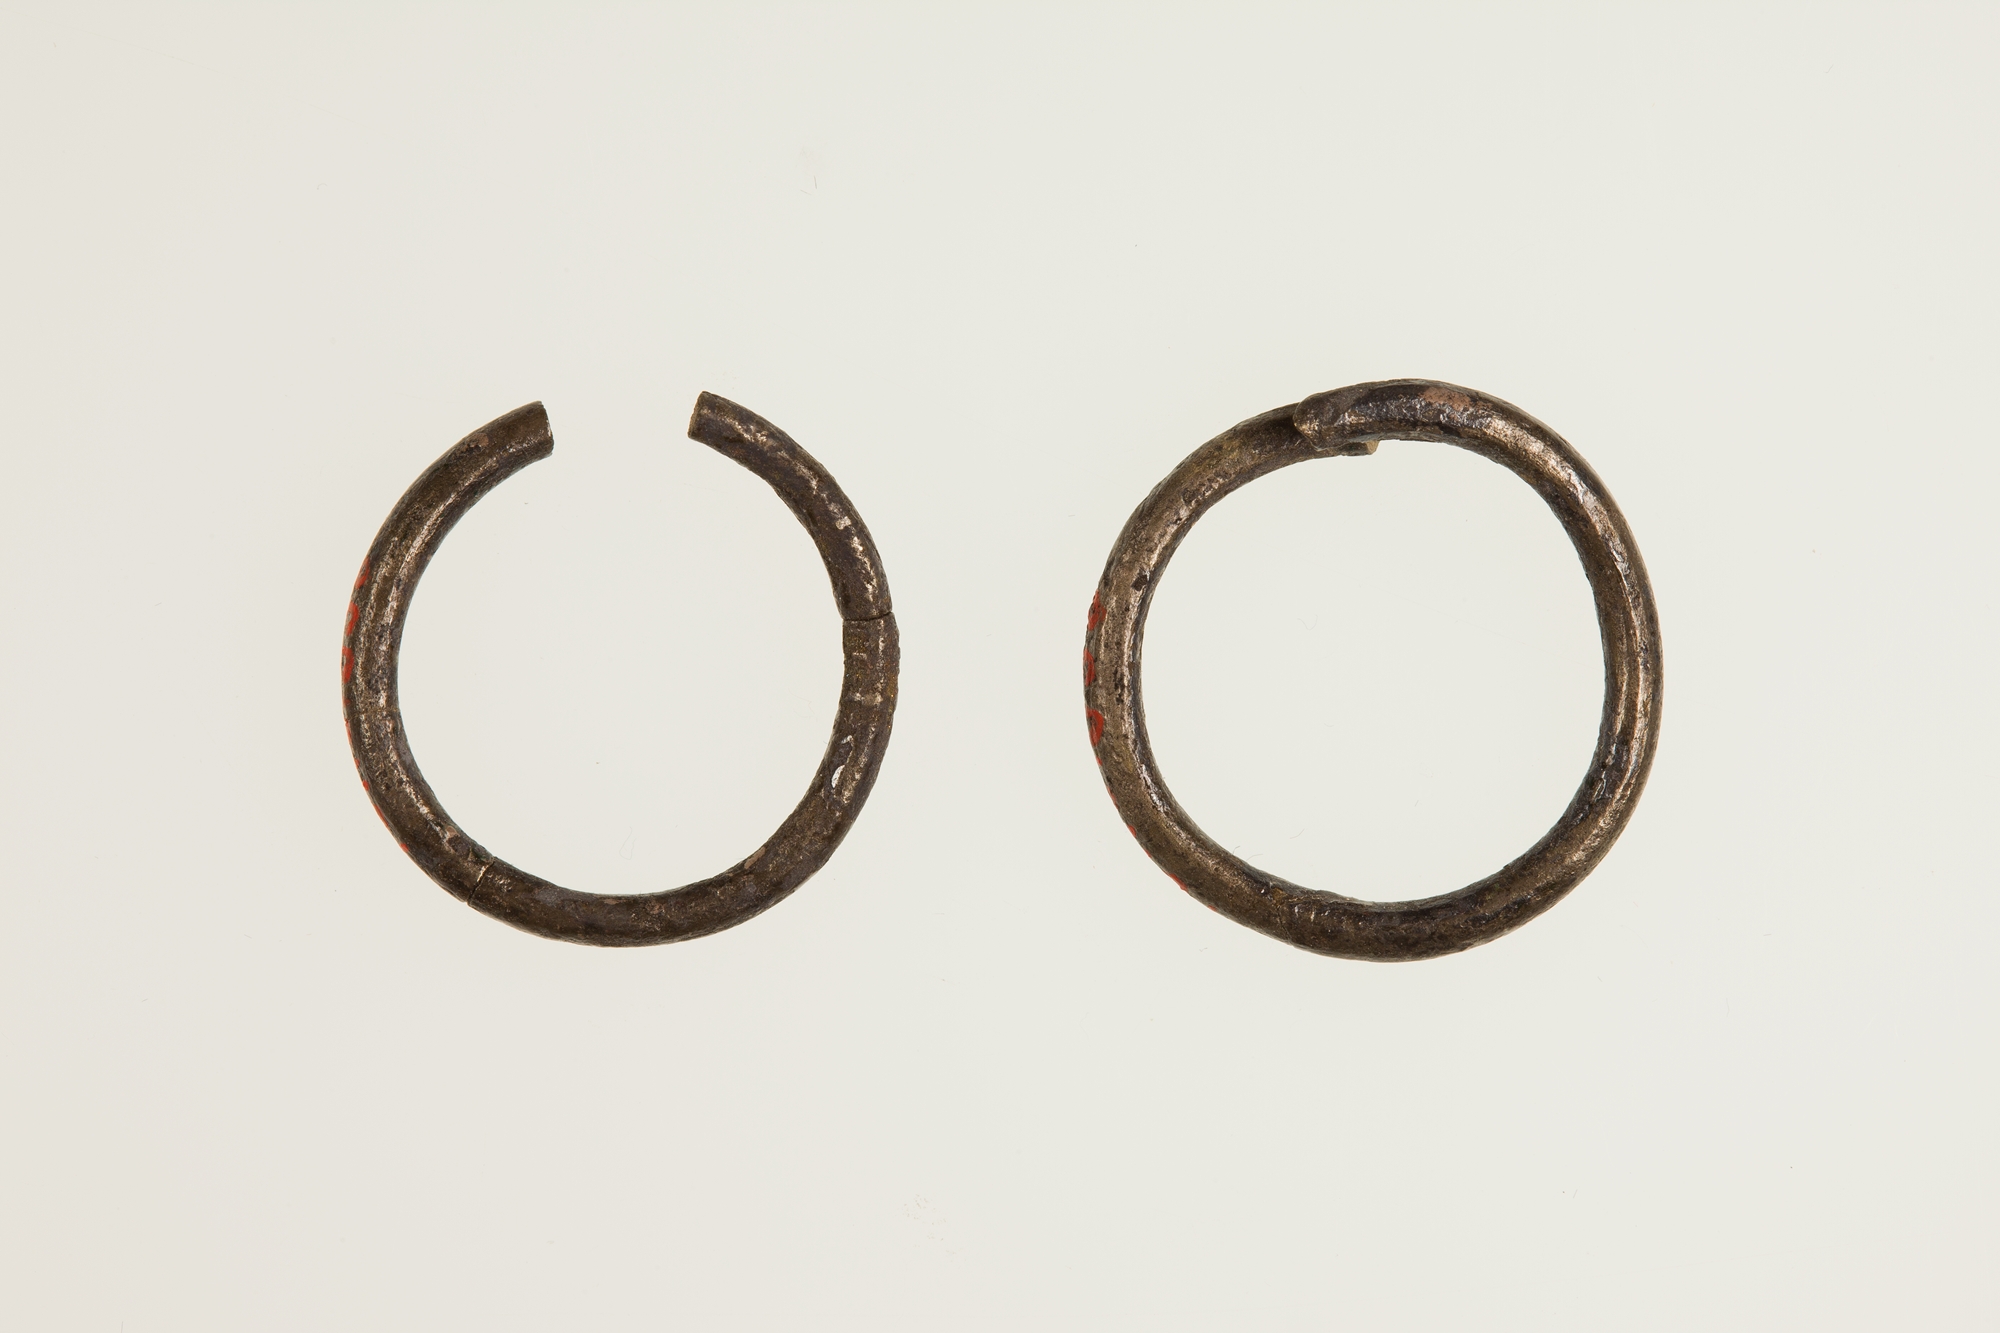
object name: earring or spiral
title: Pair of Earrings (with 16.10.337)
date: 1635-1458 BCE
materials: silver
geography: egypt